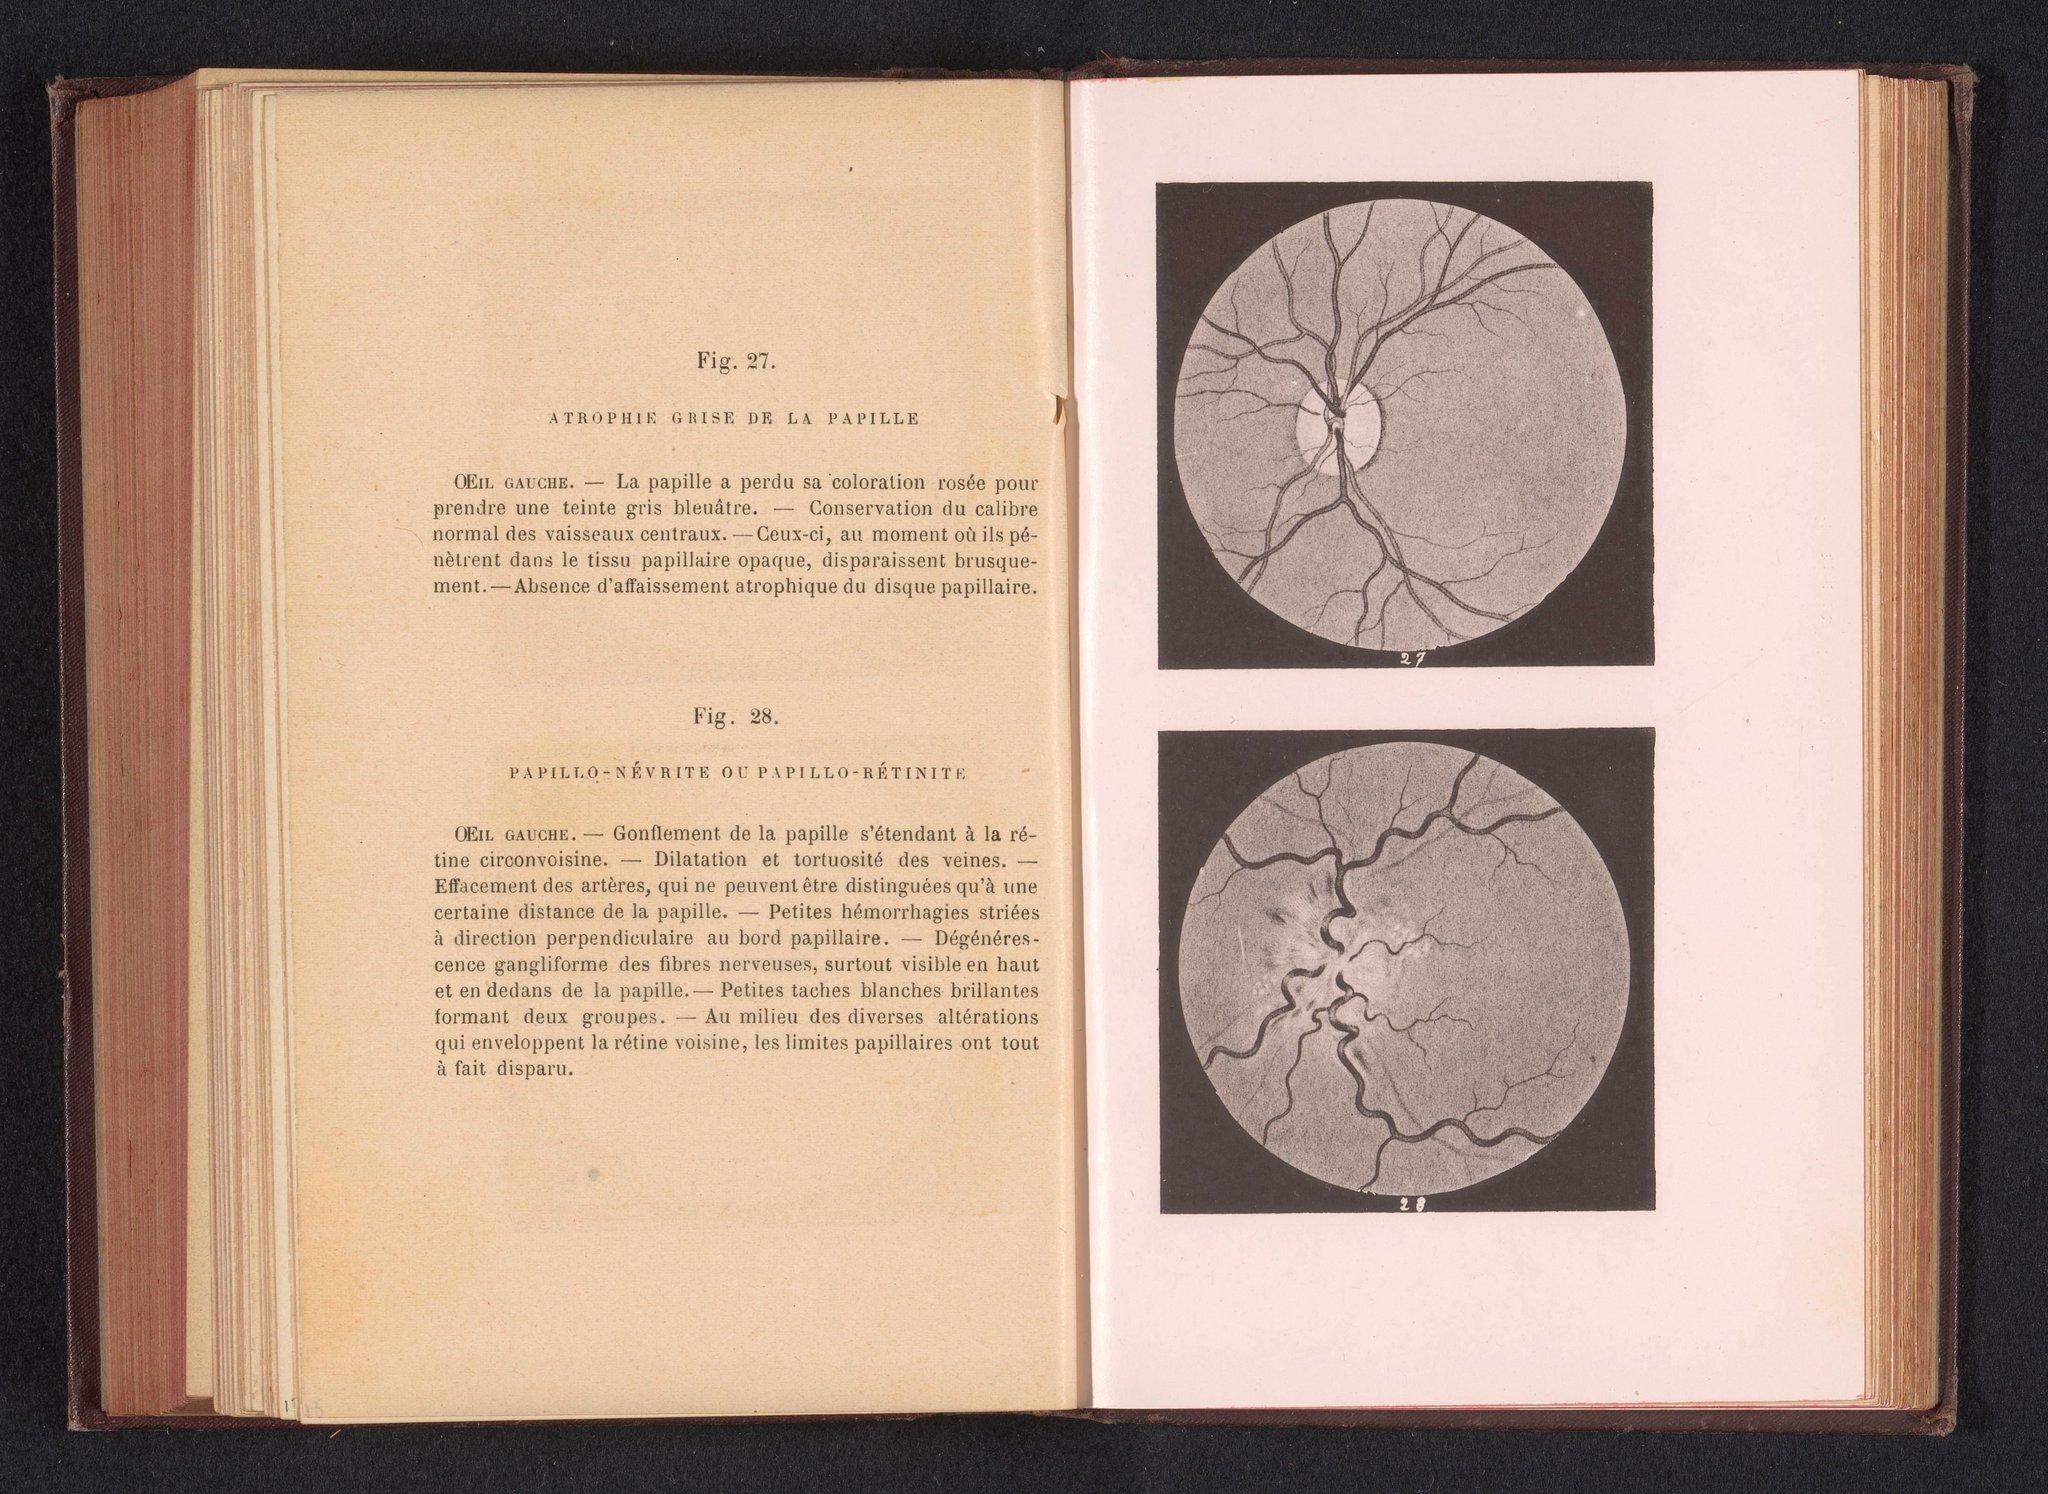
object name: reproduction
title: Fotoreproductie van twee anatomische tekeningen van atrofie en een zenuwontsteking in een oog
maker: Anonymous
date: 1871-1891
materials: paper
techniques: photograph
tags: anatomy (non-medical), eyes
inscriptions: inscription: ‘Fig. 27. Atrophie grise de la papille Fig. 28. Papillo-névrite ou papillo-rétinite’